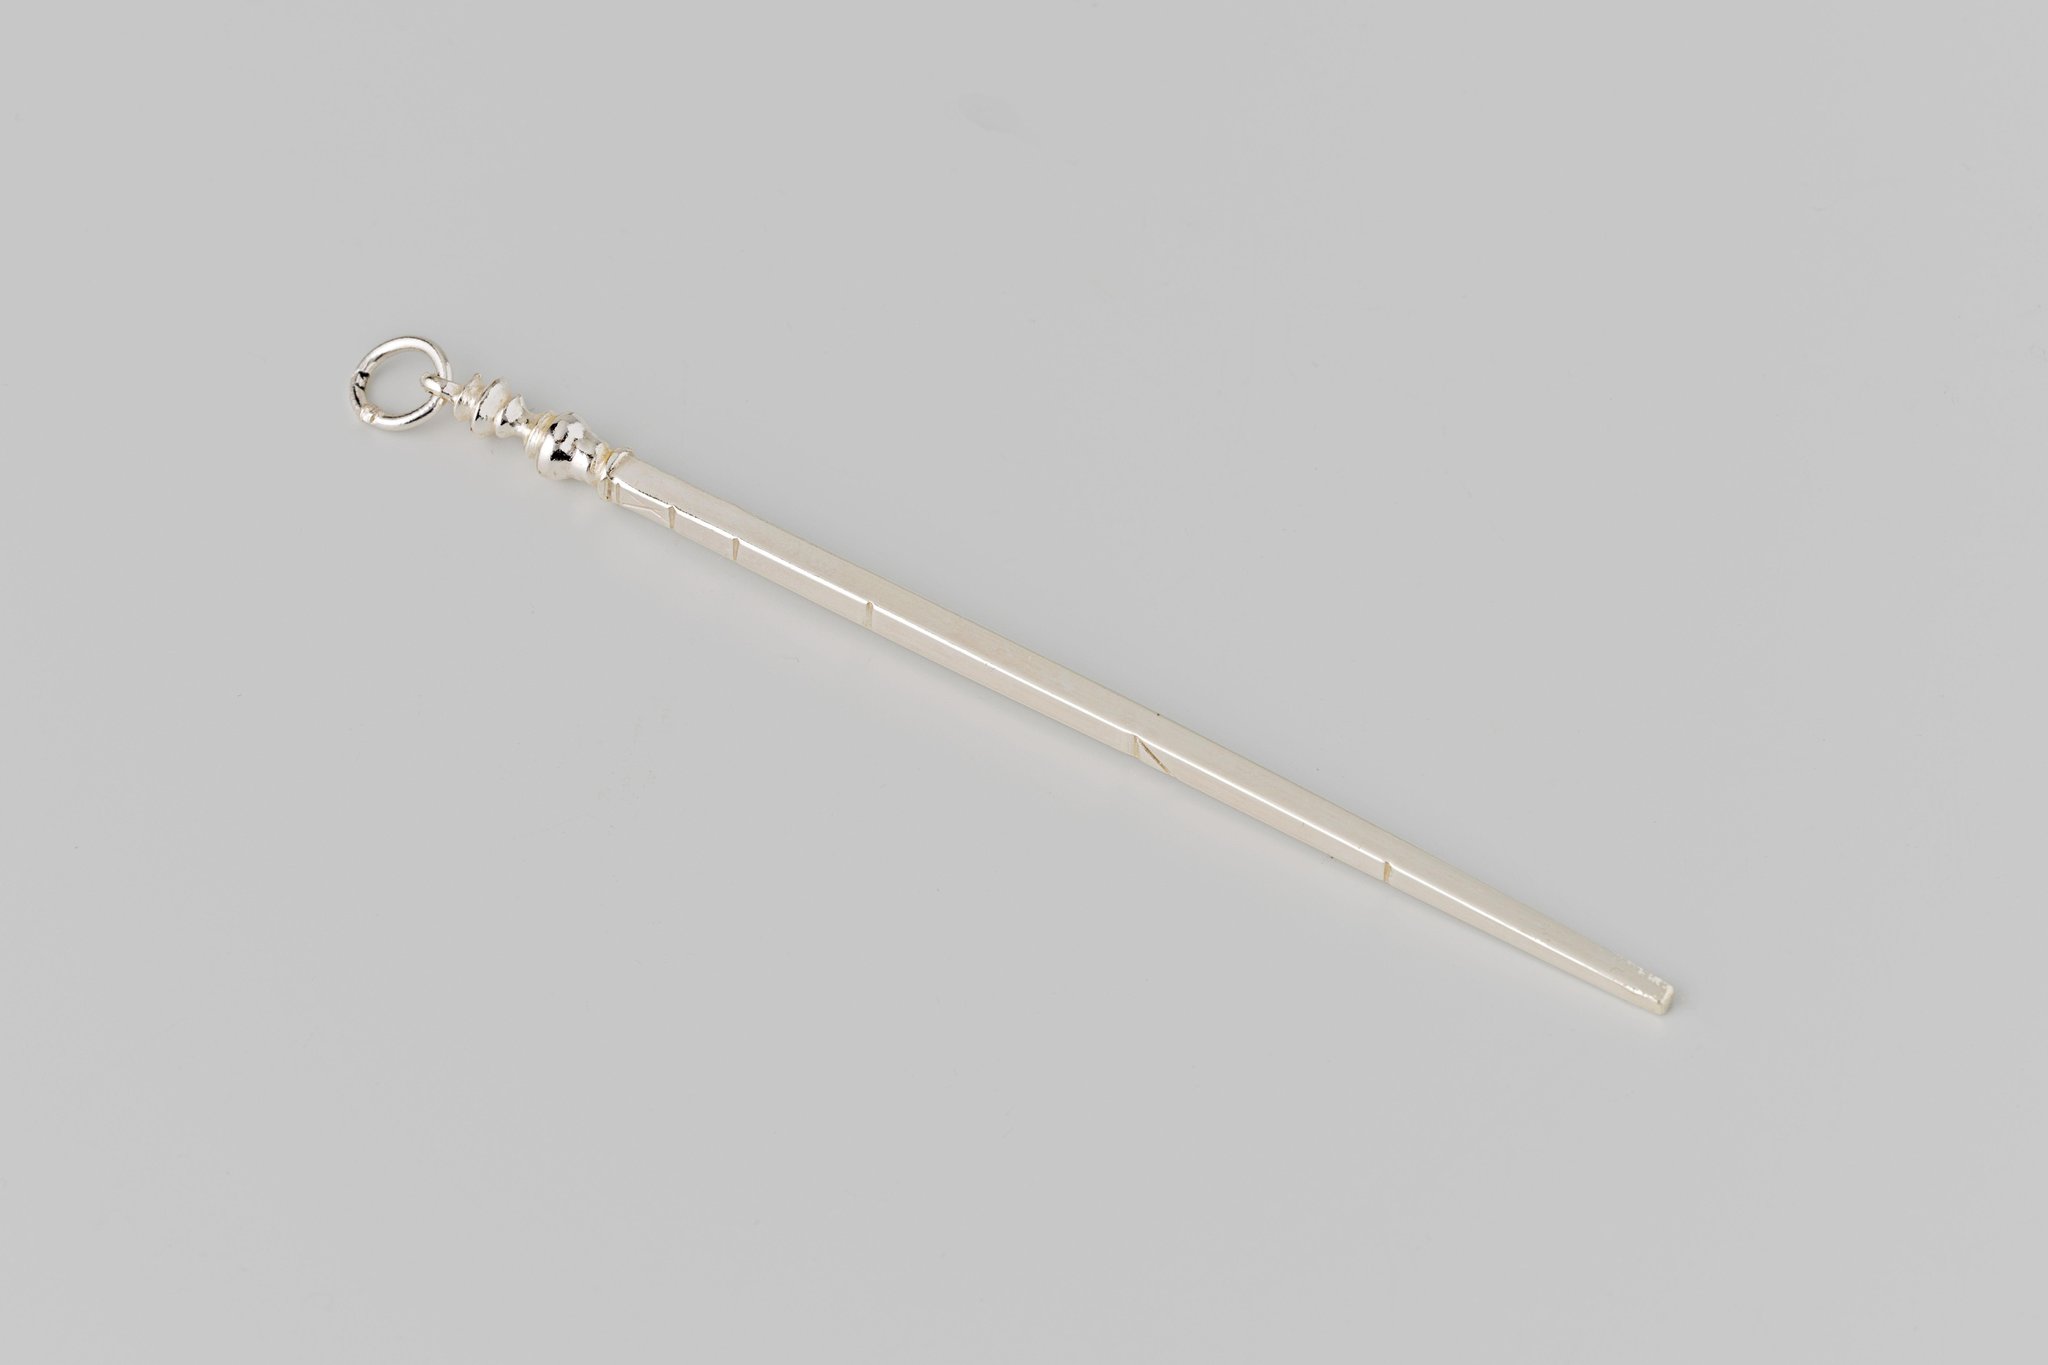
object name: ellemaat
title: Ellenmaat van zilver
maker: wessel jansen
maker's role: silversmith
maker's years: -1696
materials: silver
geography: amsterdam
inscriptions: maker's mark: ‘W (Citroen 1975, nr. 903)’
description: Ellenmaat van zilver, vierkante lat met maatverdeling, gedraaid handvat met ring.